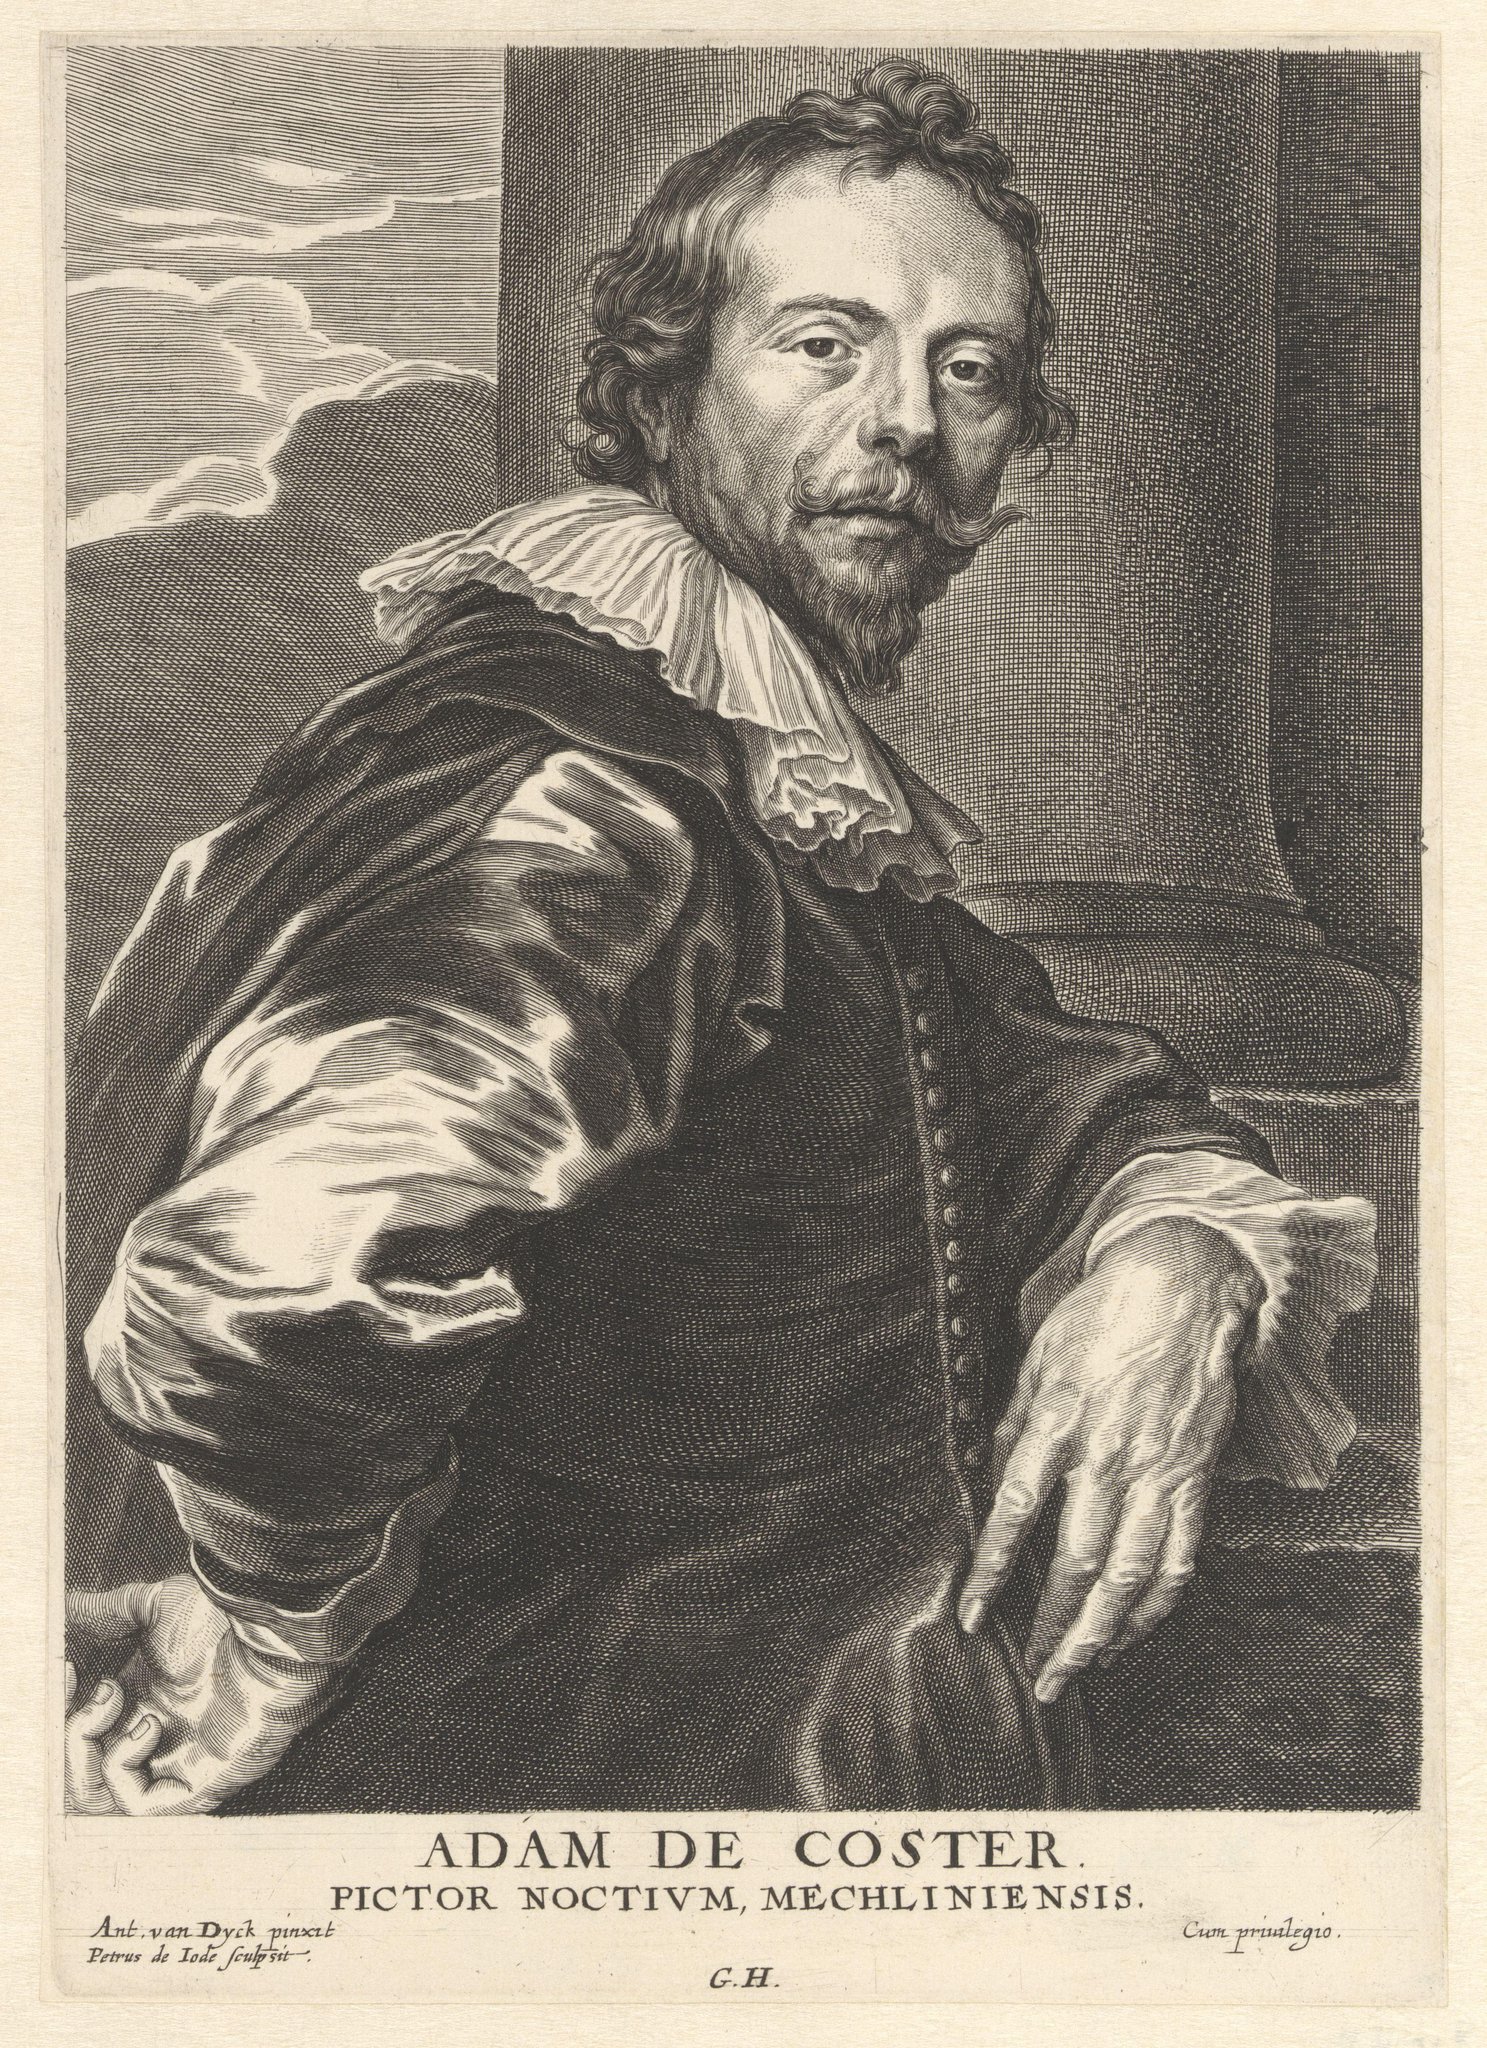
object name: print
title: Portret van Adam de Coster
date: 1628-1670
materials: paper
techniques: engraving, etching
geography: antwerp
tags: mechelen, antwerp, painter, adam de coster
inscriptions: collector's mark: Lugt 240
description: Portret van de schilder Adam de Coster, ten halven lijve. Met zijn linkerarm leunt hij tegen een zuil. Zijn rechterhand houdt hij op zijn rug. In de marge de naam en het beroep van de geportretteerde.